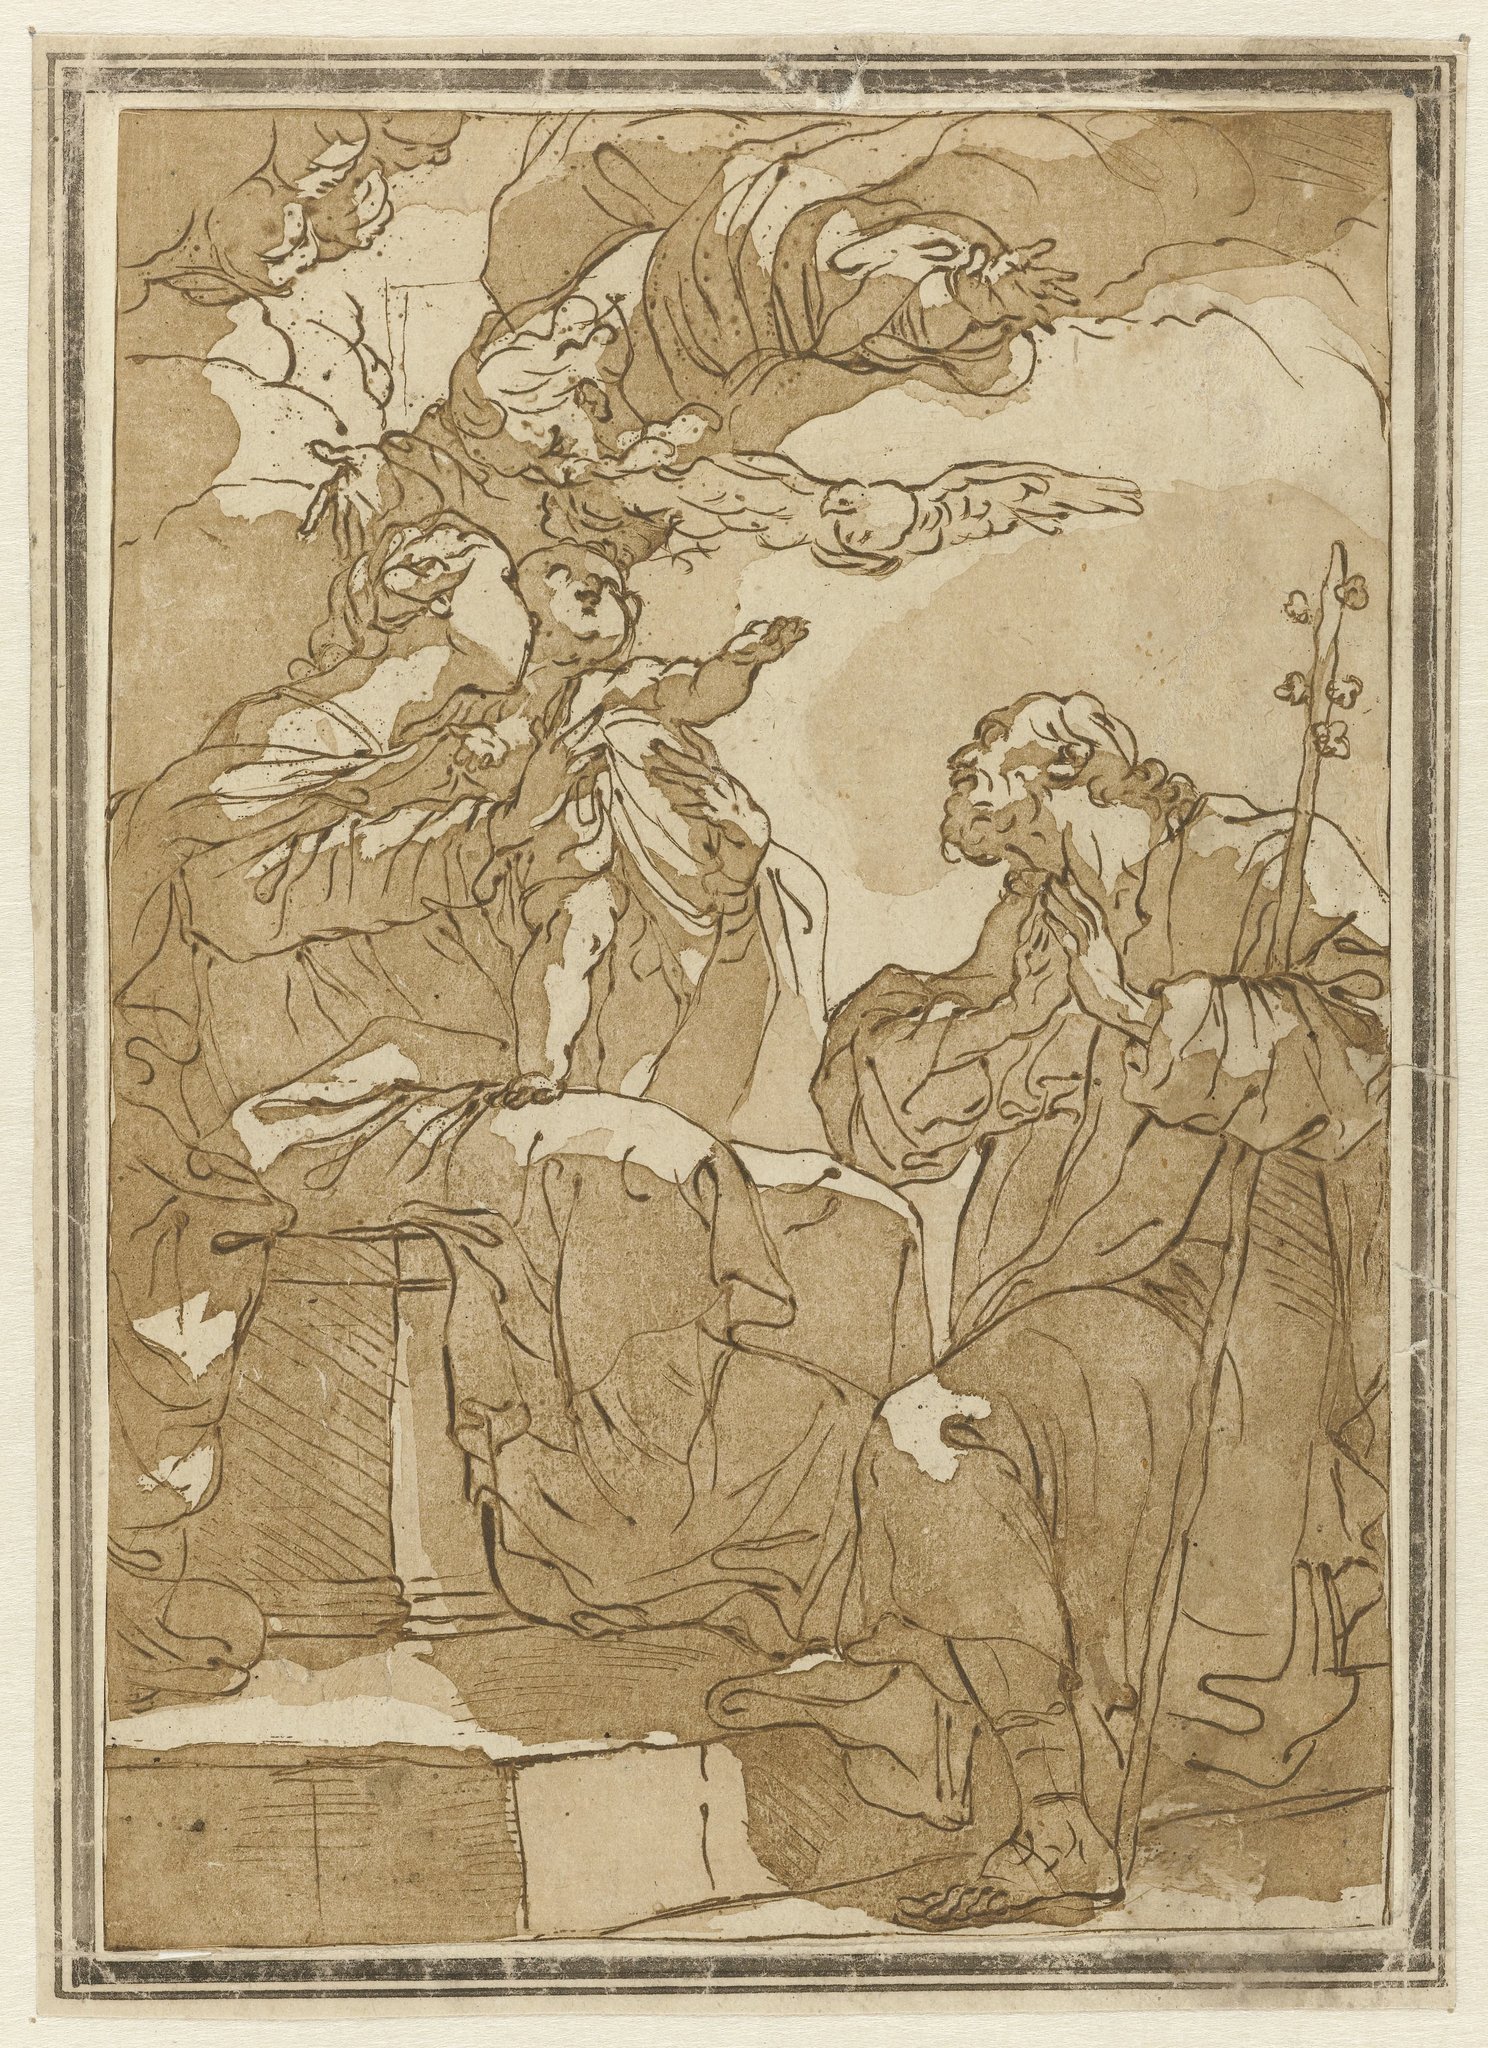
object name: print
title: Heilige Familie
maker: gaetano gandolfi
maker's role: draughtsman, painter, print maker, sculptor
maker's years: 1734-1802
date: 1744-1802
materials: paper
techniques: aquatint, etching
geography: italy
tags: holy family, and derived representations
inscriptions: inscription: ‘Bel disegno/Sacra famiglia colla SS Trinita’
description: Links zit Maria met het Kind op een troon. Rechts knielt Jozef met een bloeiende staf in zijn arm. Van boven dalen God de Vader en de Heilige Geest neer op Maria en het Kind.